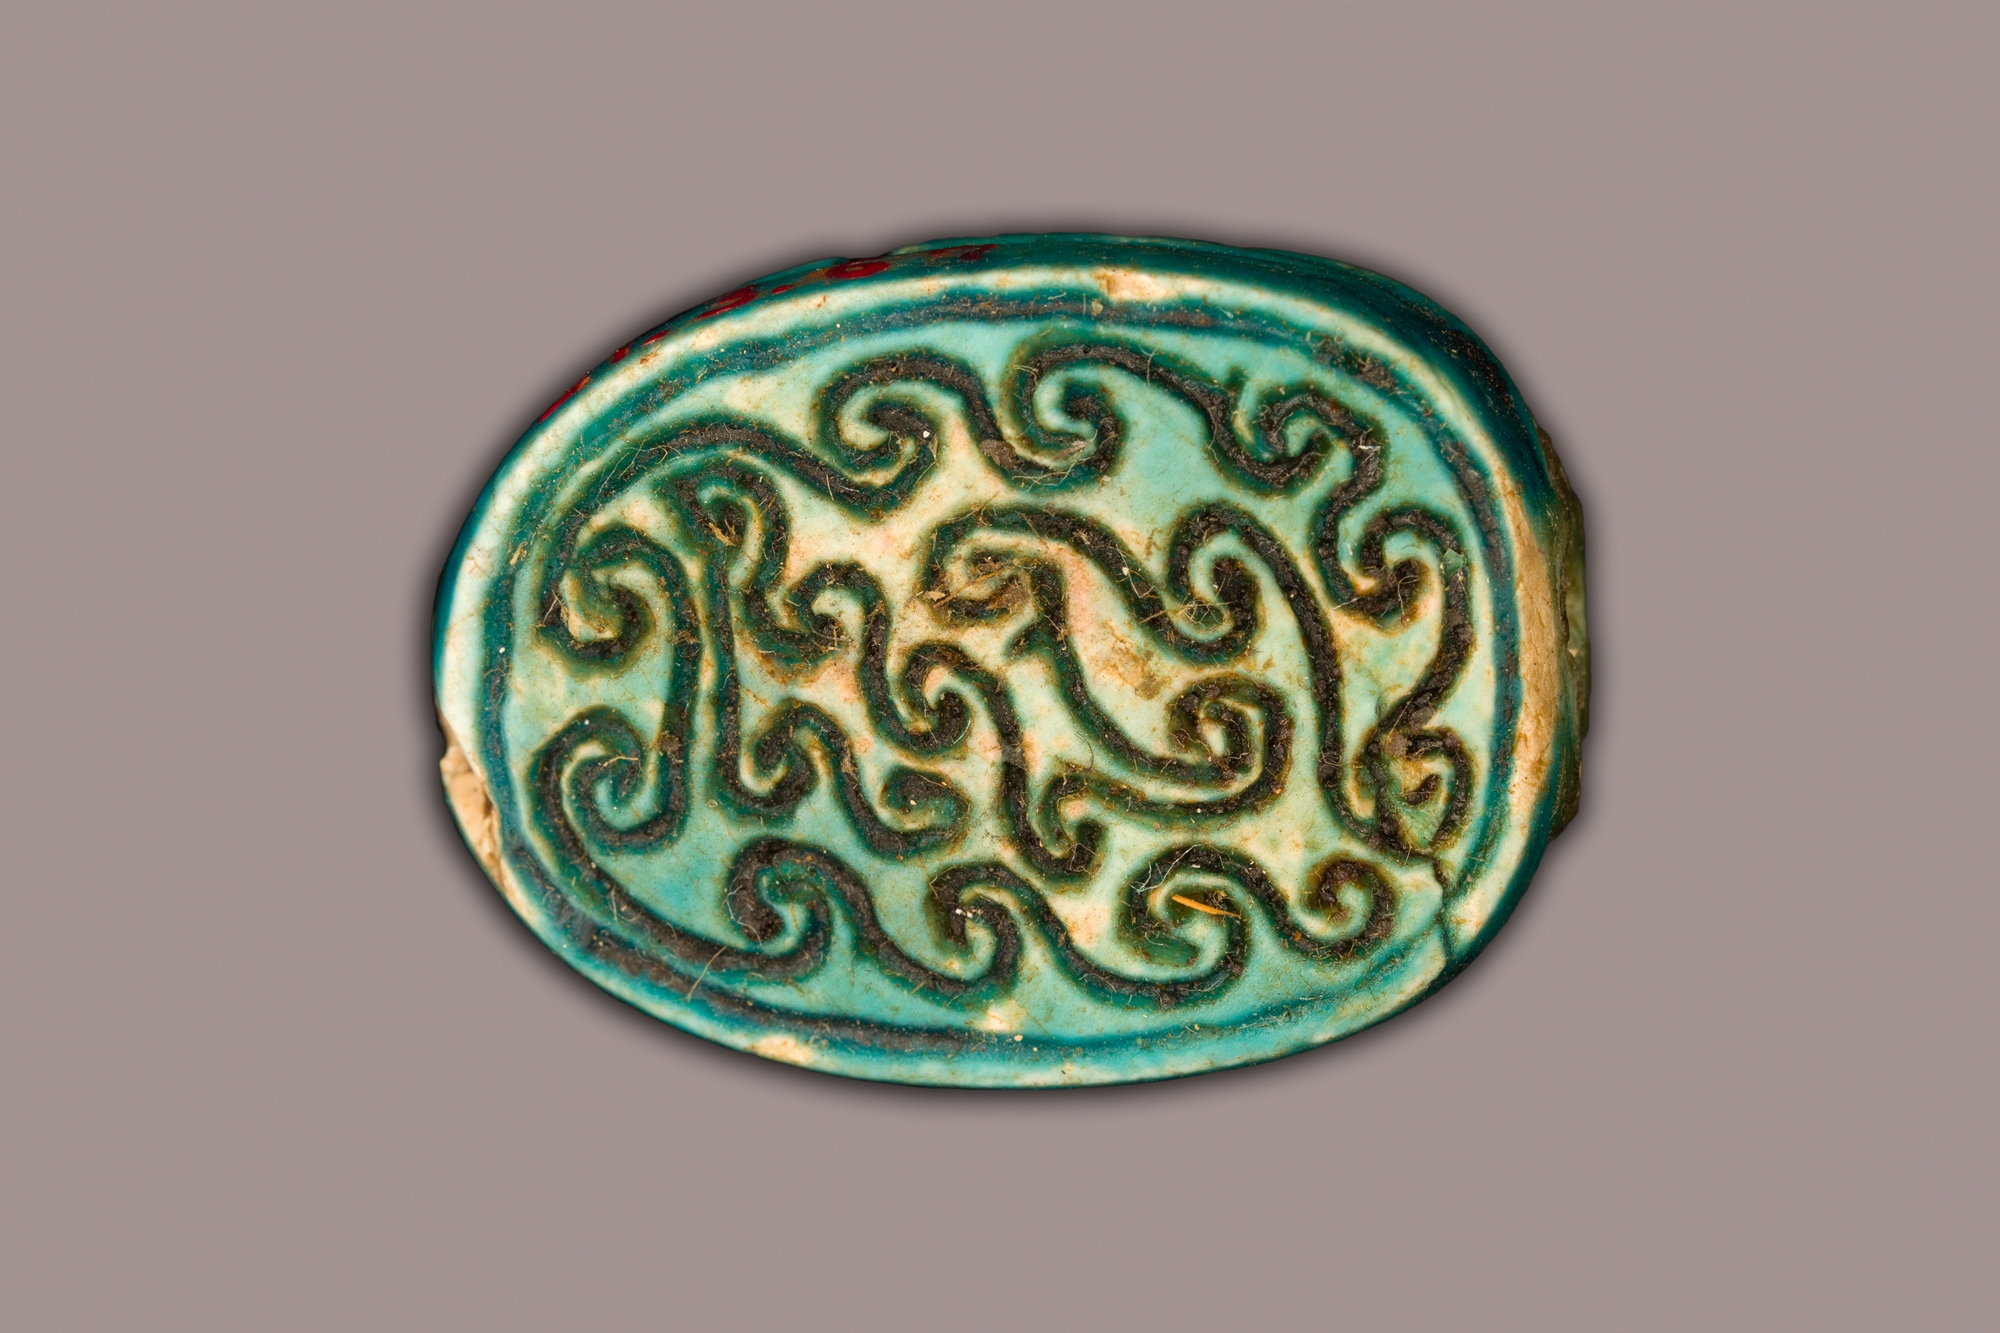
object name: scarab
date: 2124-1504 BCE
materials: stone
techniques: glazing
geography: egypt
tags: scarabs